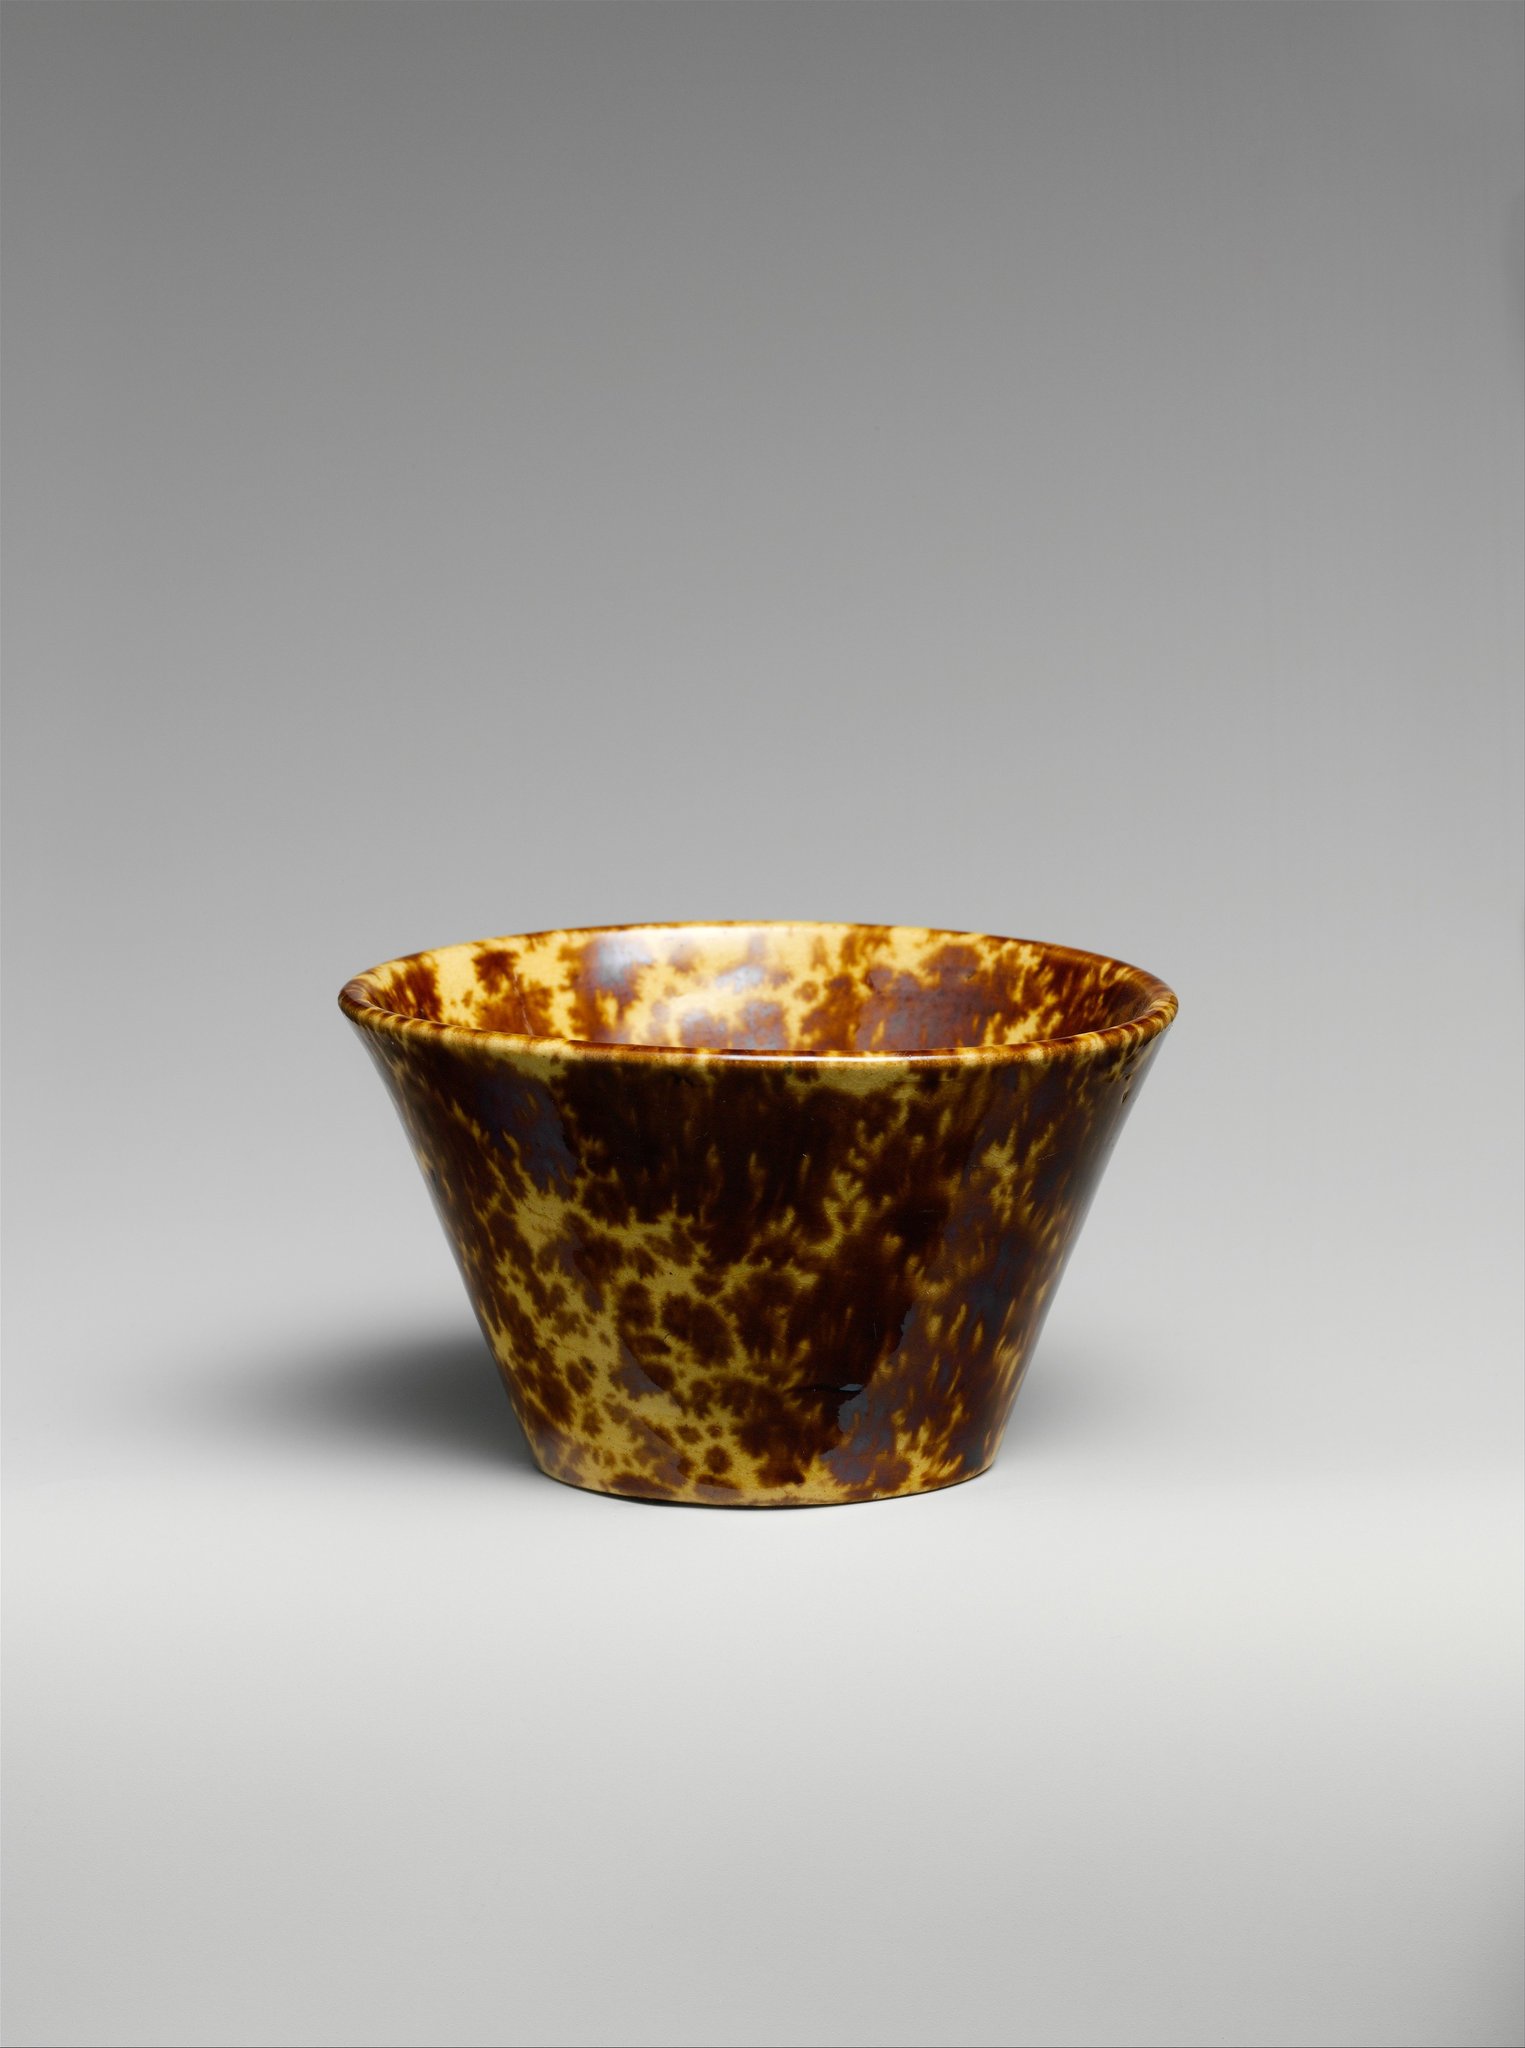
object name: cup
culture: american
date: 1850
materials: earthenware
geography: united states